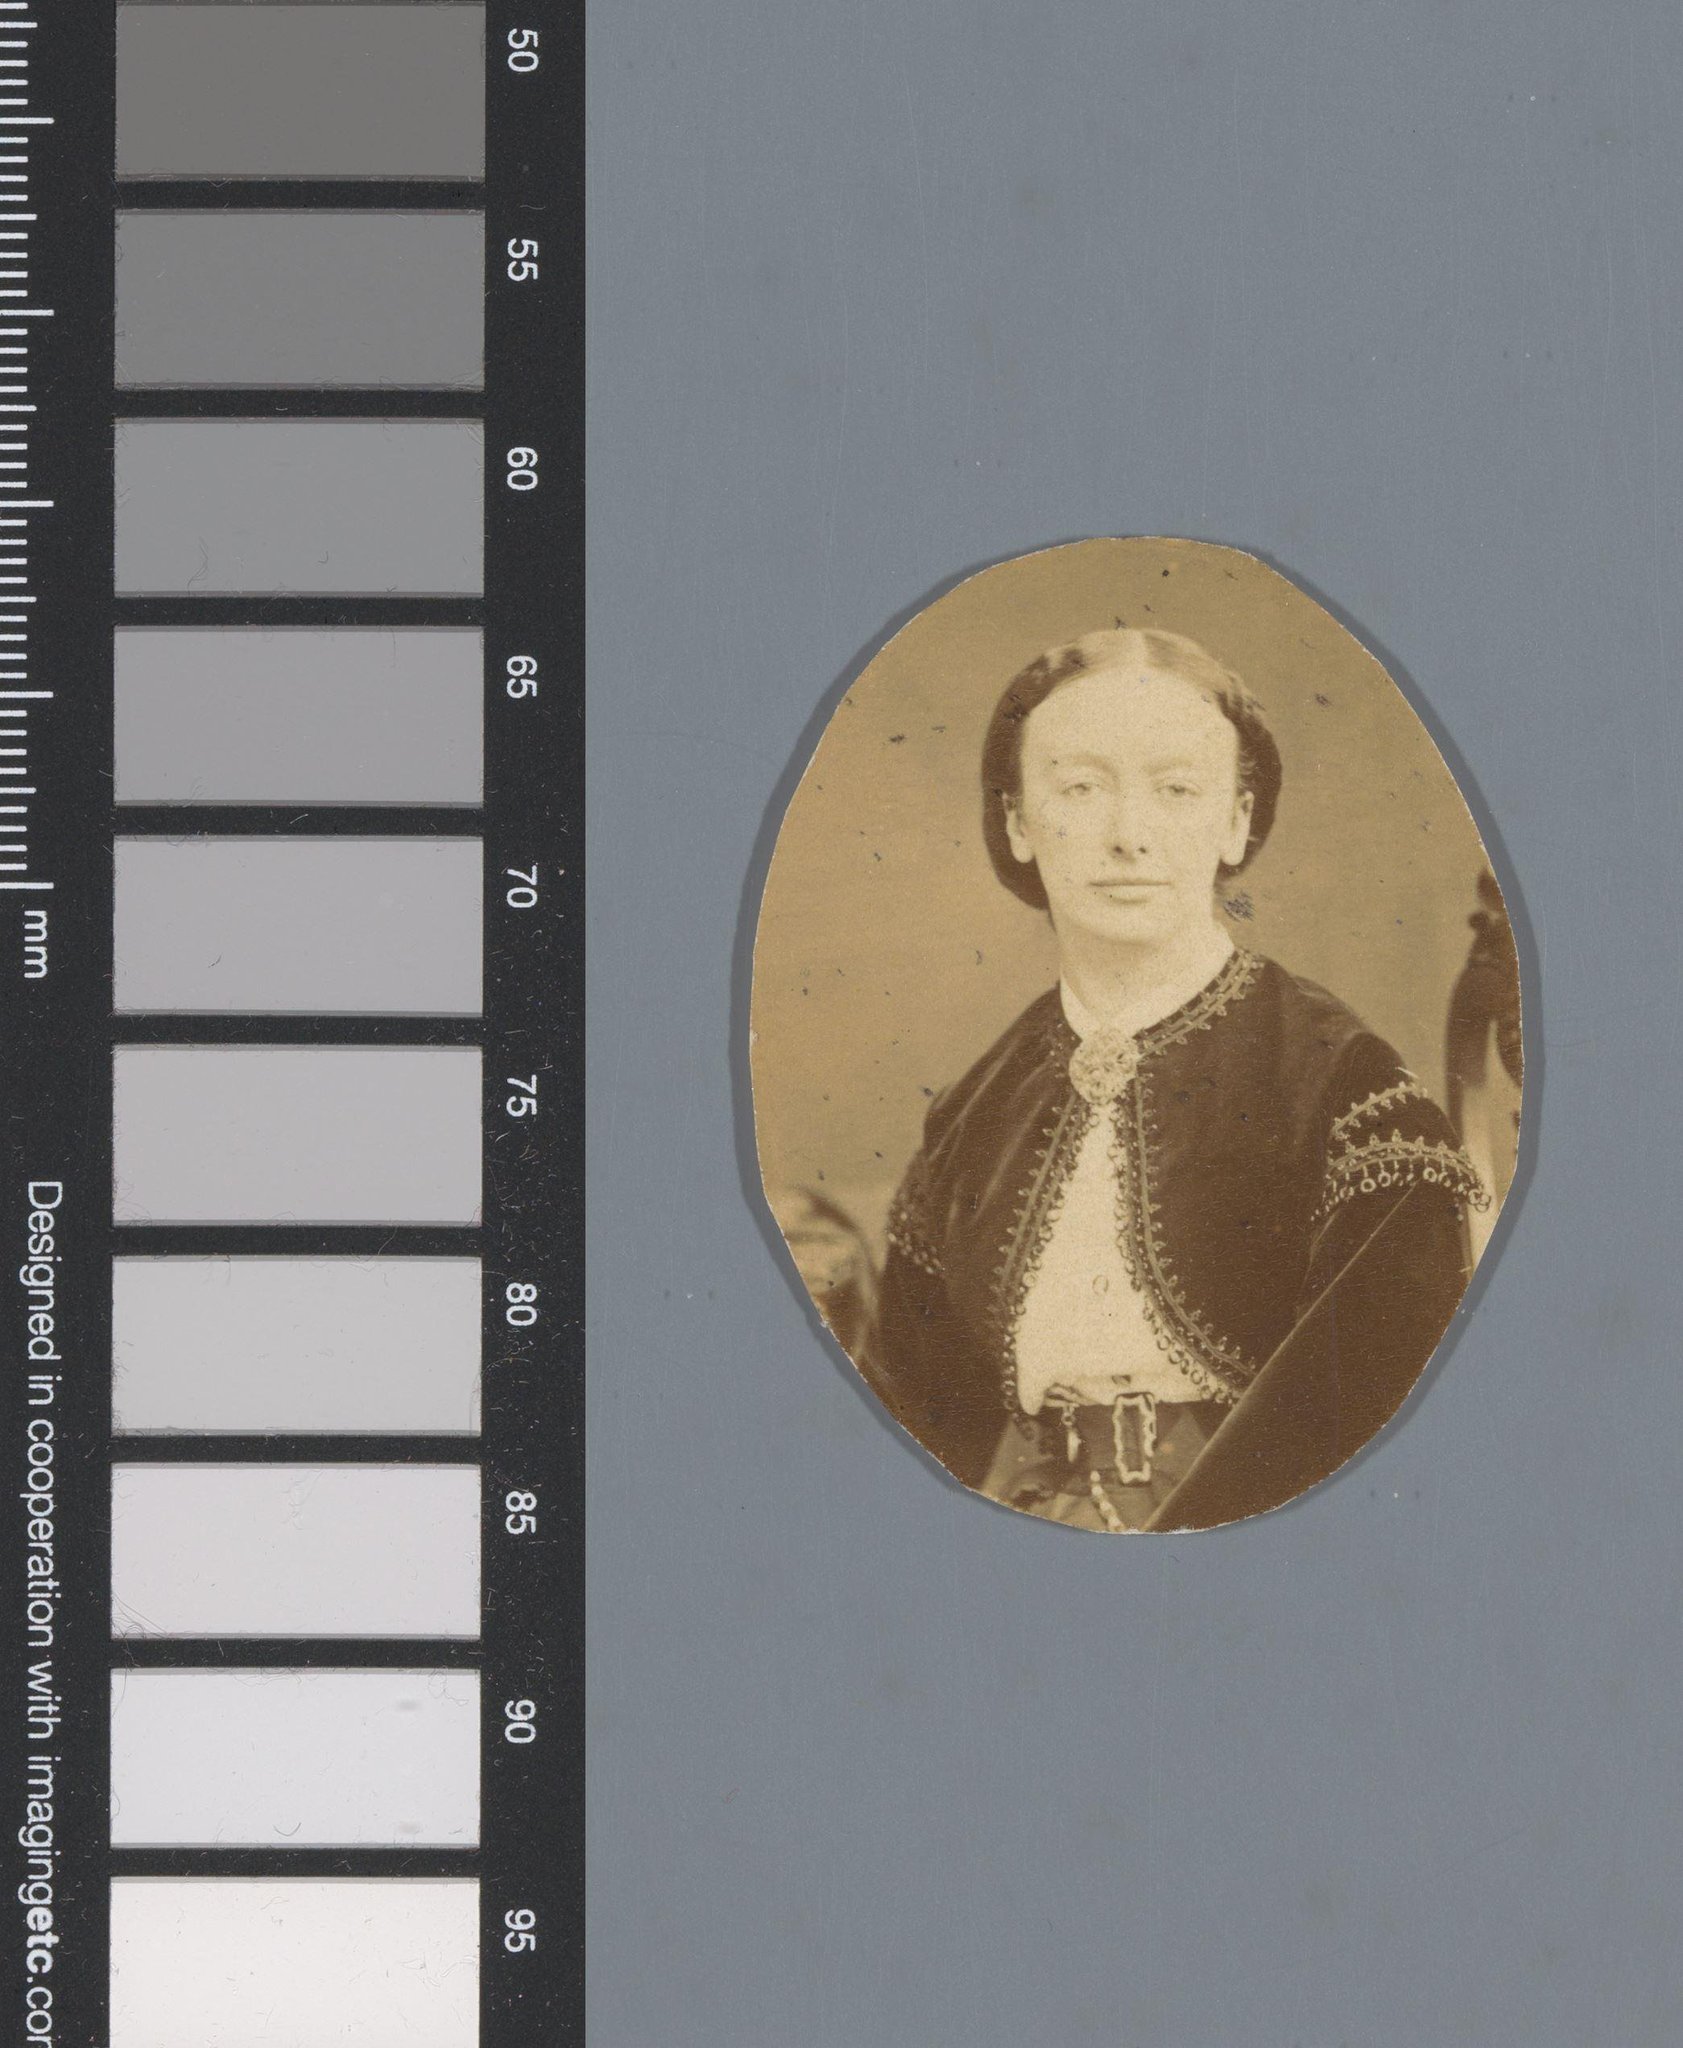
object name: photograph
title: Portret van een onbekende vrouw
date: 1850-1875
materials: cardboard, photographic support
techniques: albumen print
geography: london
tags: adult woman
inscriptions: inscription: ‘Southwell Brothers Photographers Royal, 16 & 22, Baker Street Londen’